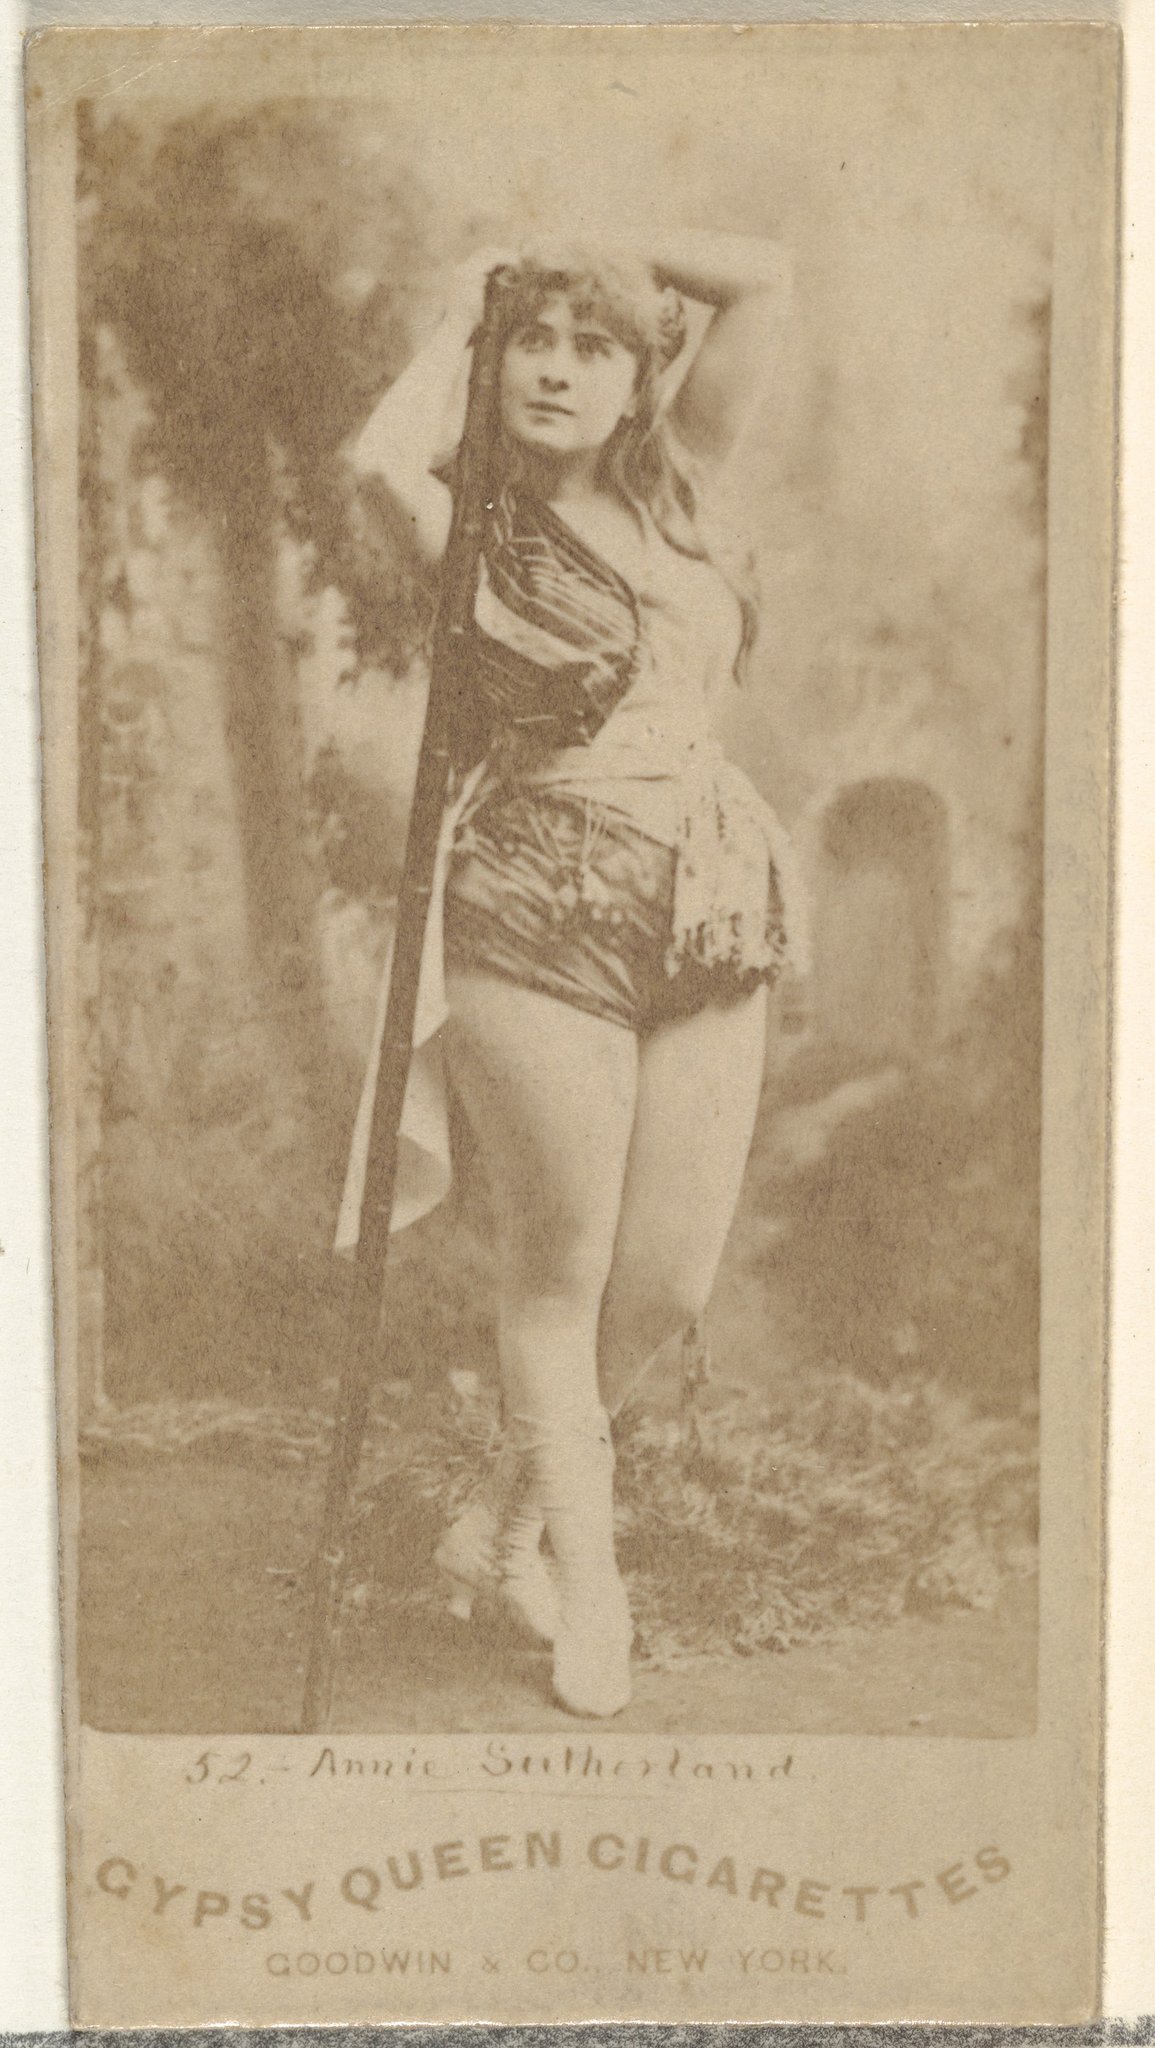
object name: photograph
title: Annie Sutherland, from the Actors and Actresses series (N171) for Gypsy Queen Cigarettes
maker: goodwin & company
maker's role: publisher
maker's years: 1850-1950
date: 1886-1890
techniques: albumen silver print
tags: portraits,women,actresses